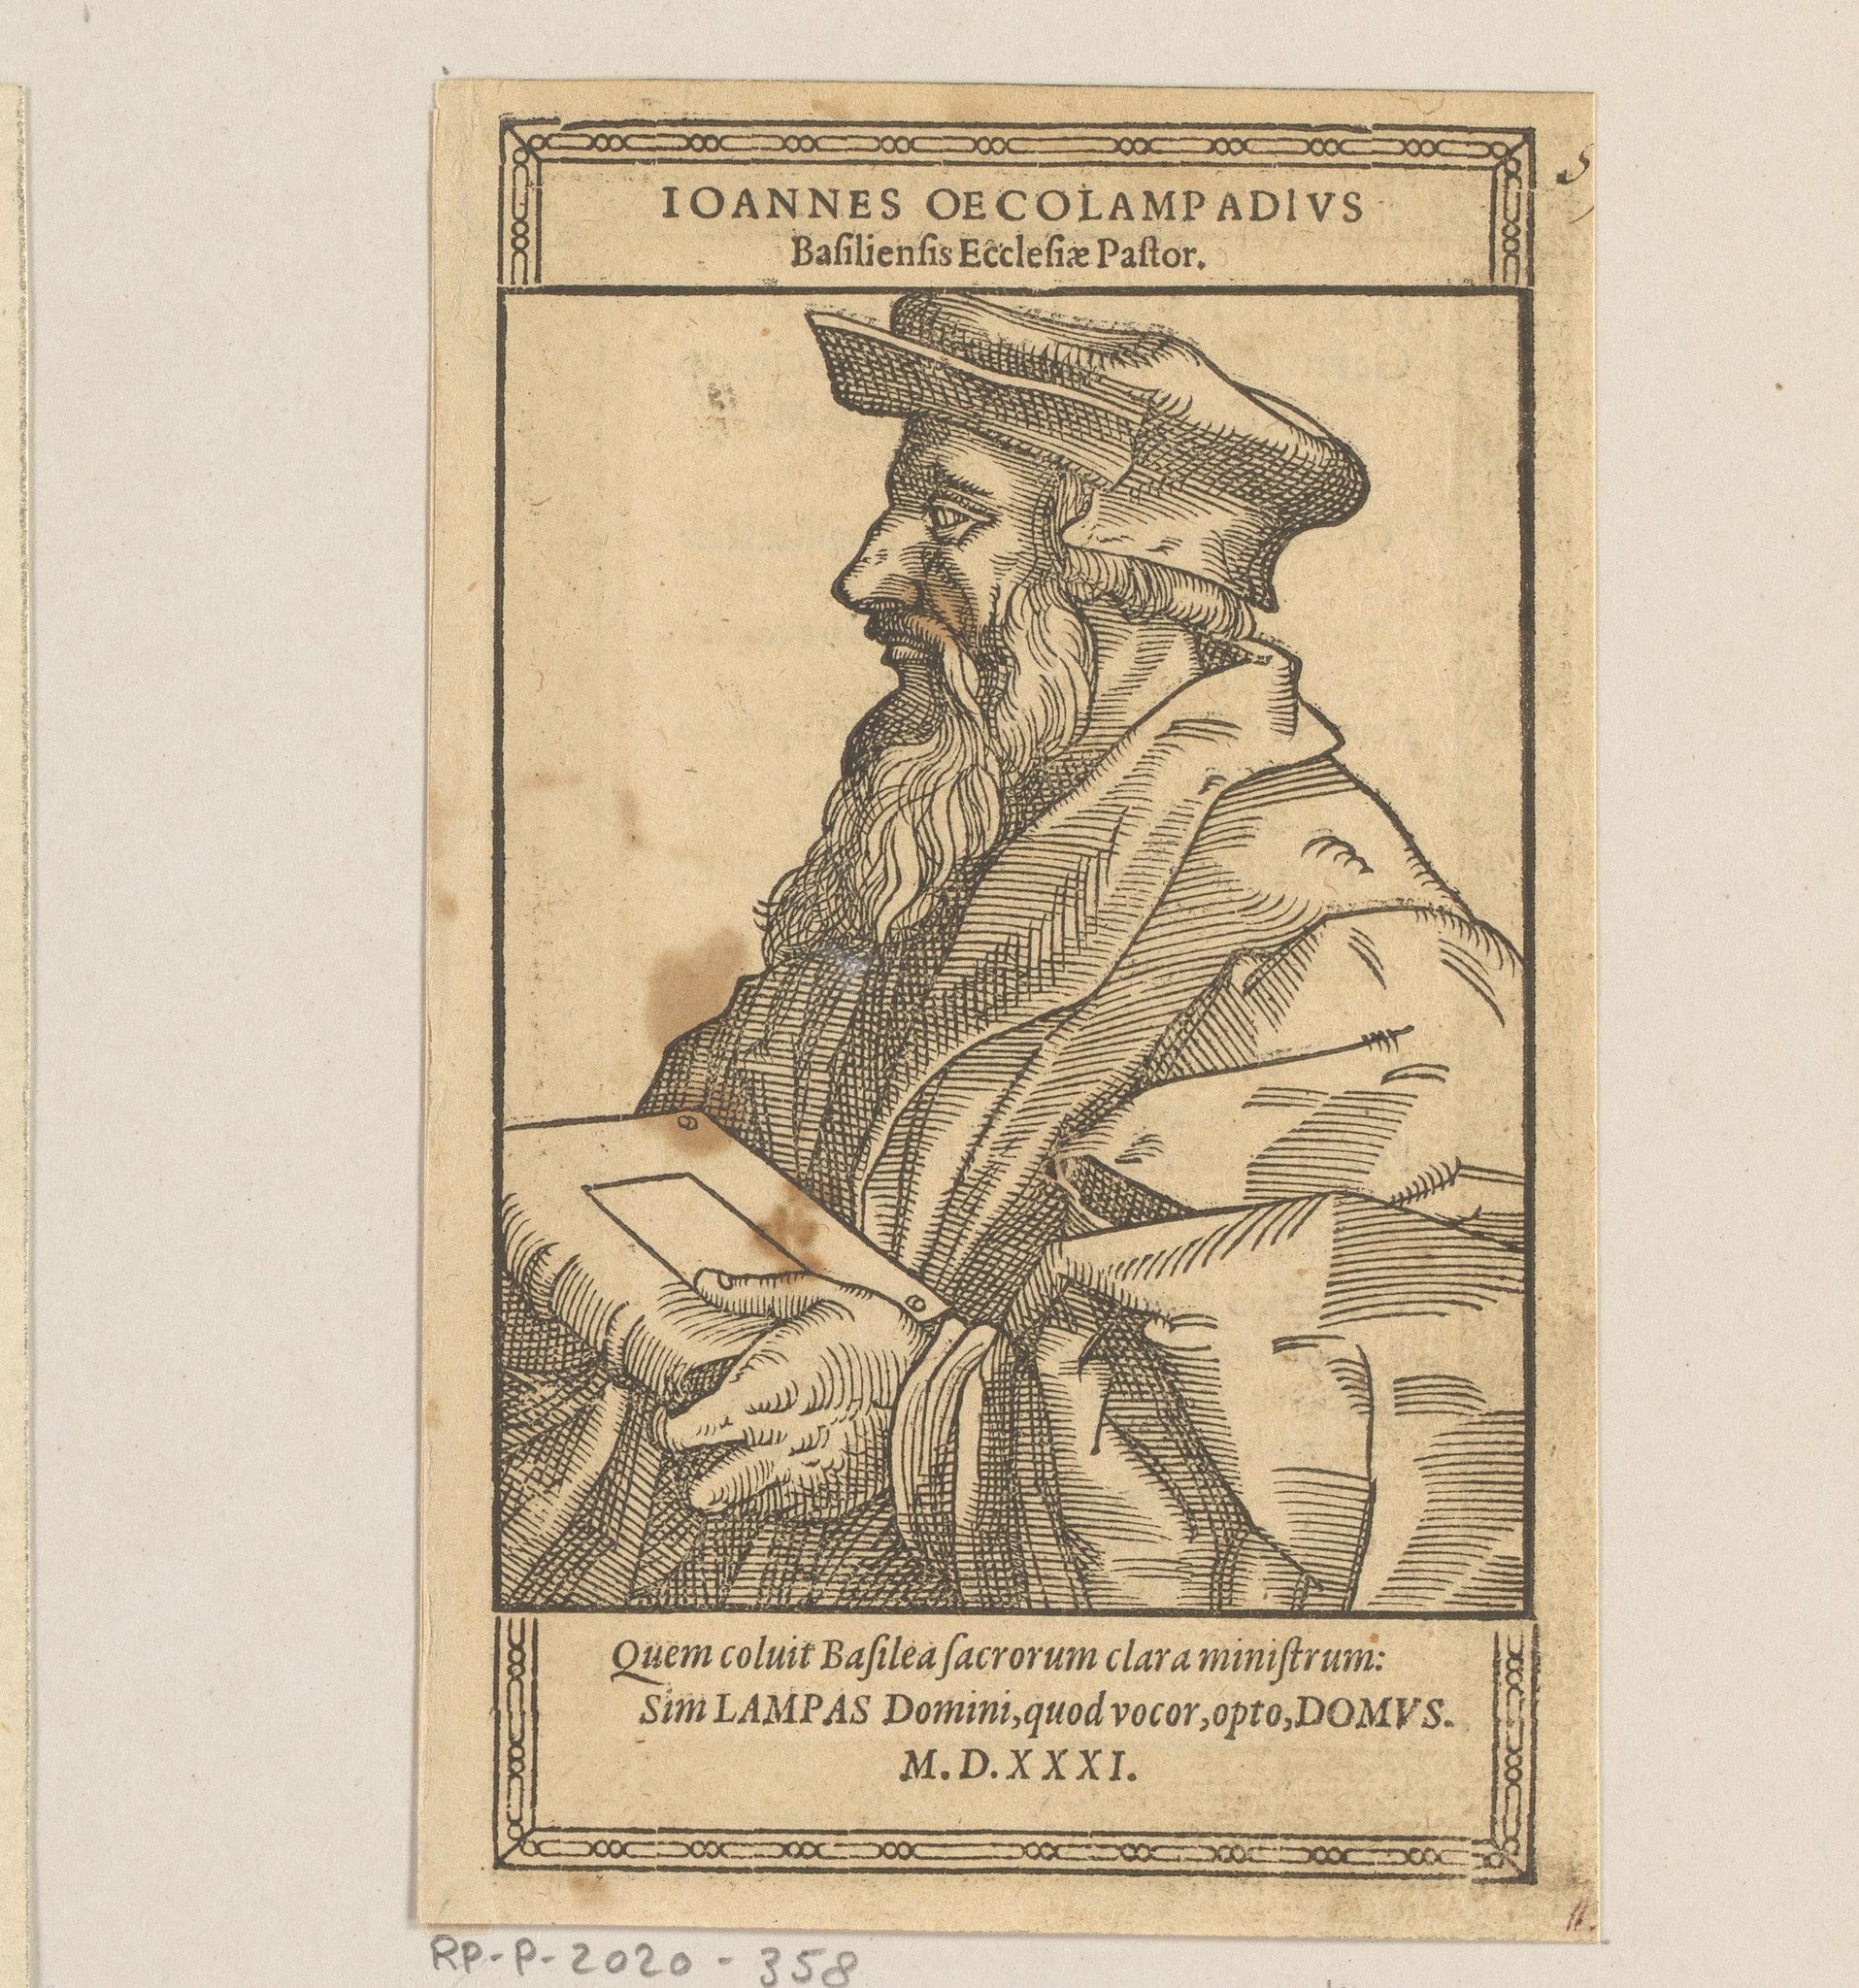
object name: print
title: Portret van Johannes Oecolampadius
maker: bernhard jobin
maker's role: printer, publisher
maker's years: 1545-1593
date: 1587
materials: paper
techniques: letterpress printing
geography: straatsburg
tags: theologian, historical persons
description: Prent uit: Reusner, Nikolaus. Icones sive imagines virorum literis illustrium (...). Straatsburg: Bernhard Jobin, 1587. Prent ook gebruikt in de Duitse editie, uitgegeven in hetzelfde jaar, en de 1590-editie. Prent ook gebruikt in latere publicaties.